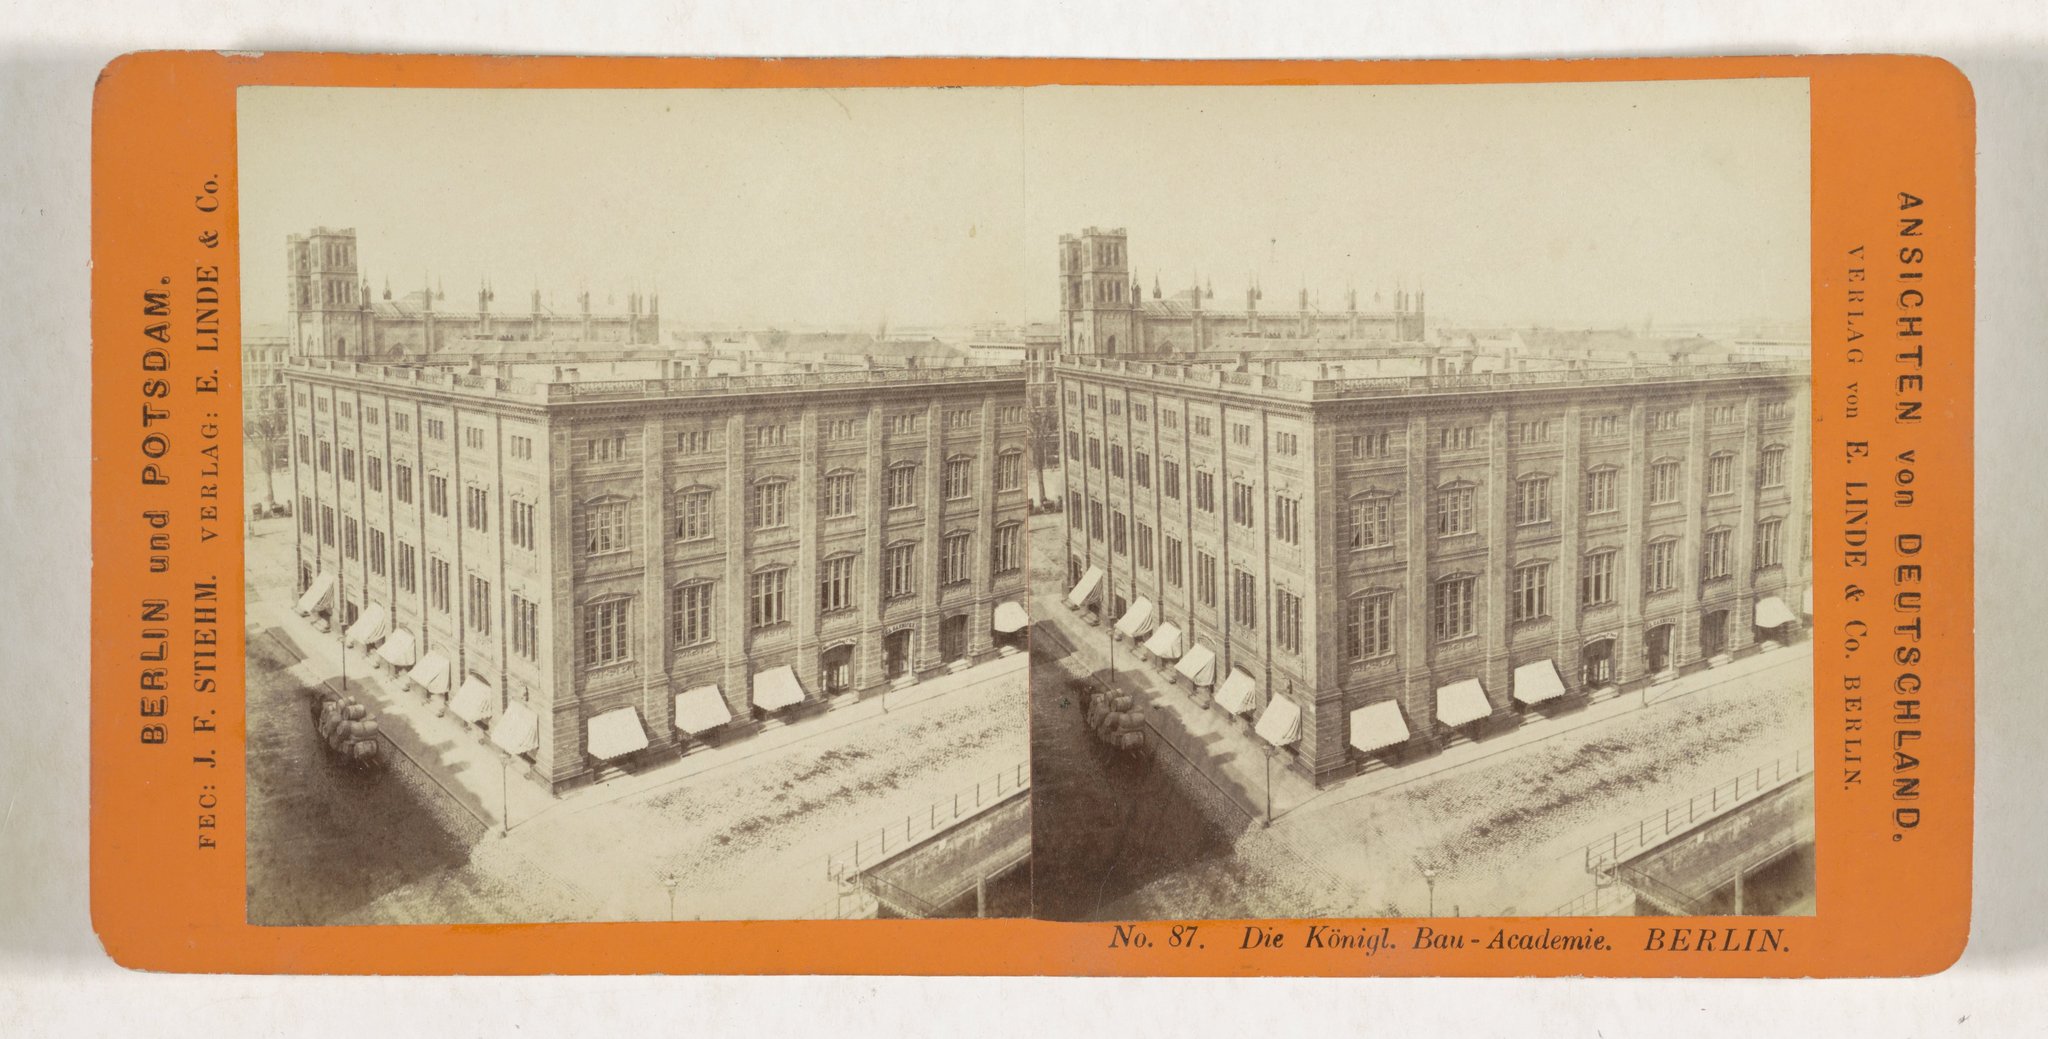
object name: stereograph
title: Berliner Bauakademie, Berlijn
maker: johann friedrich stiehm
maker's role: fotograaf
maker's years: 1826-1902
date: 1868-1870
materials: cardboard, paper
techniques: albumen print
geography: berlin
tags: edifice, e.g.: public building, department store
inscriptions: number: ‘No. 87.’